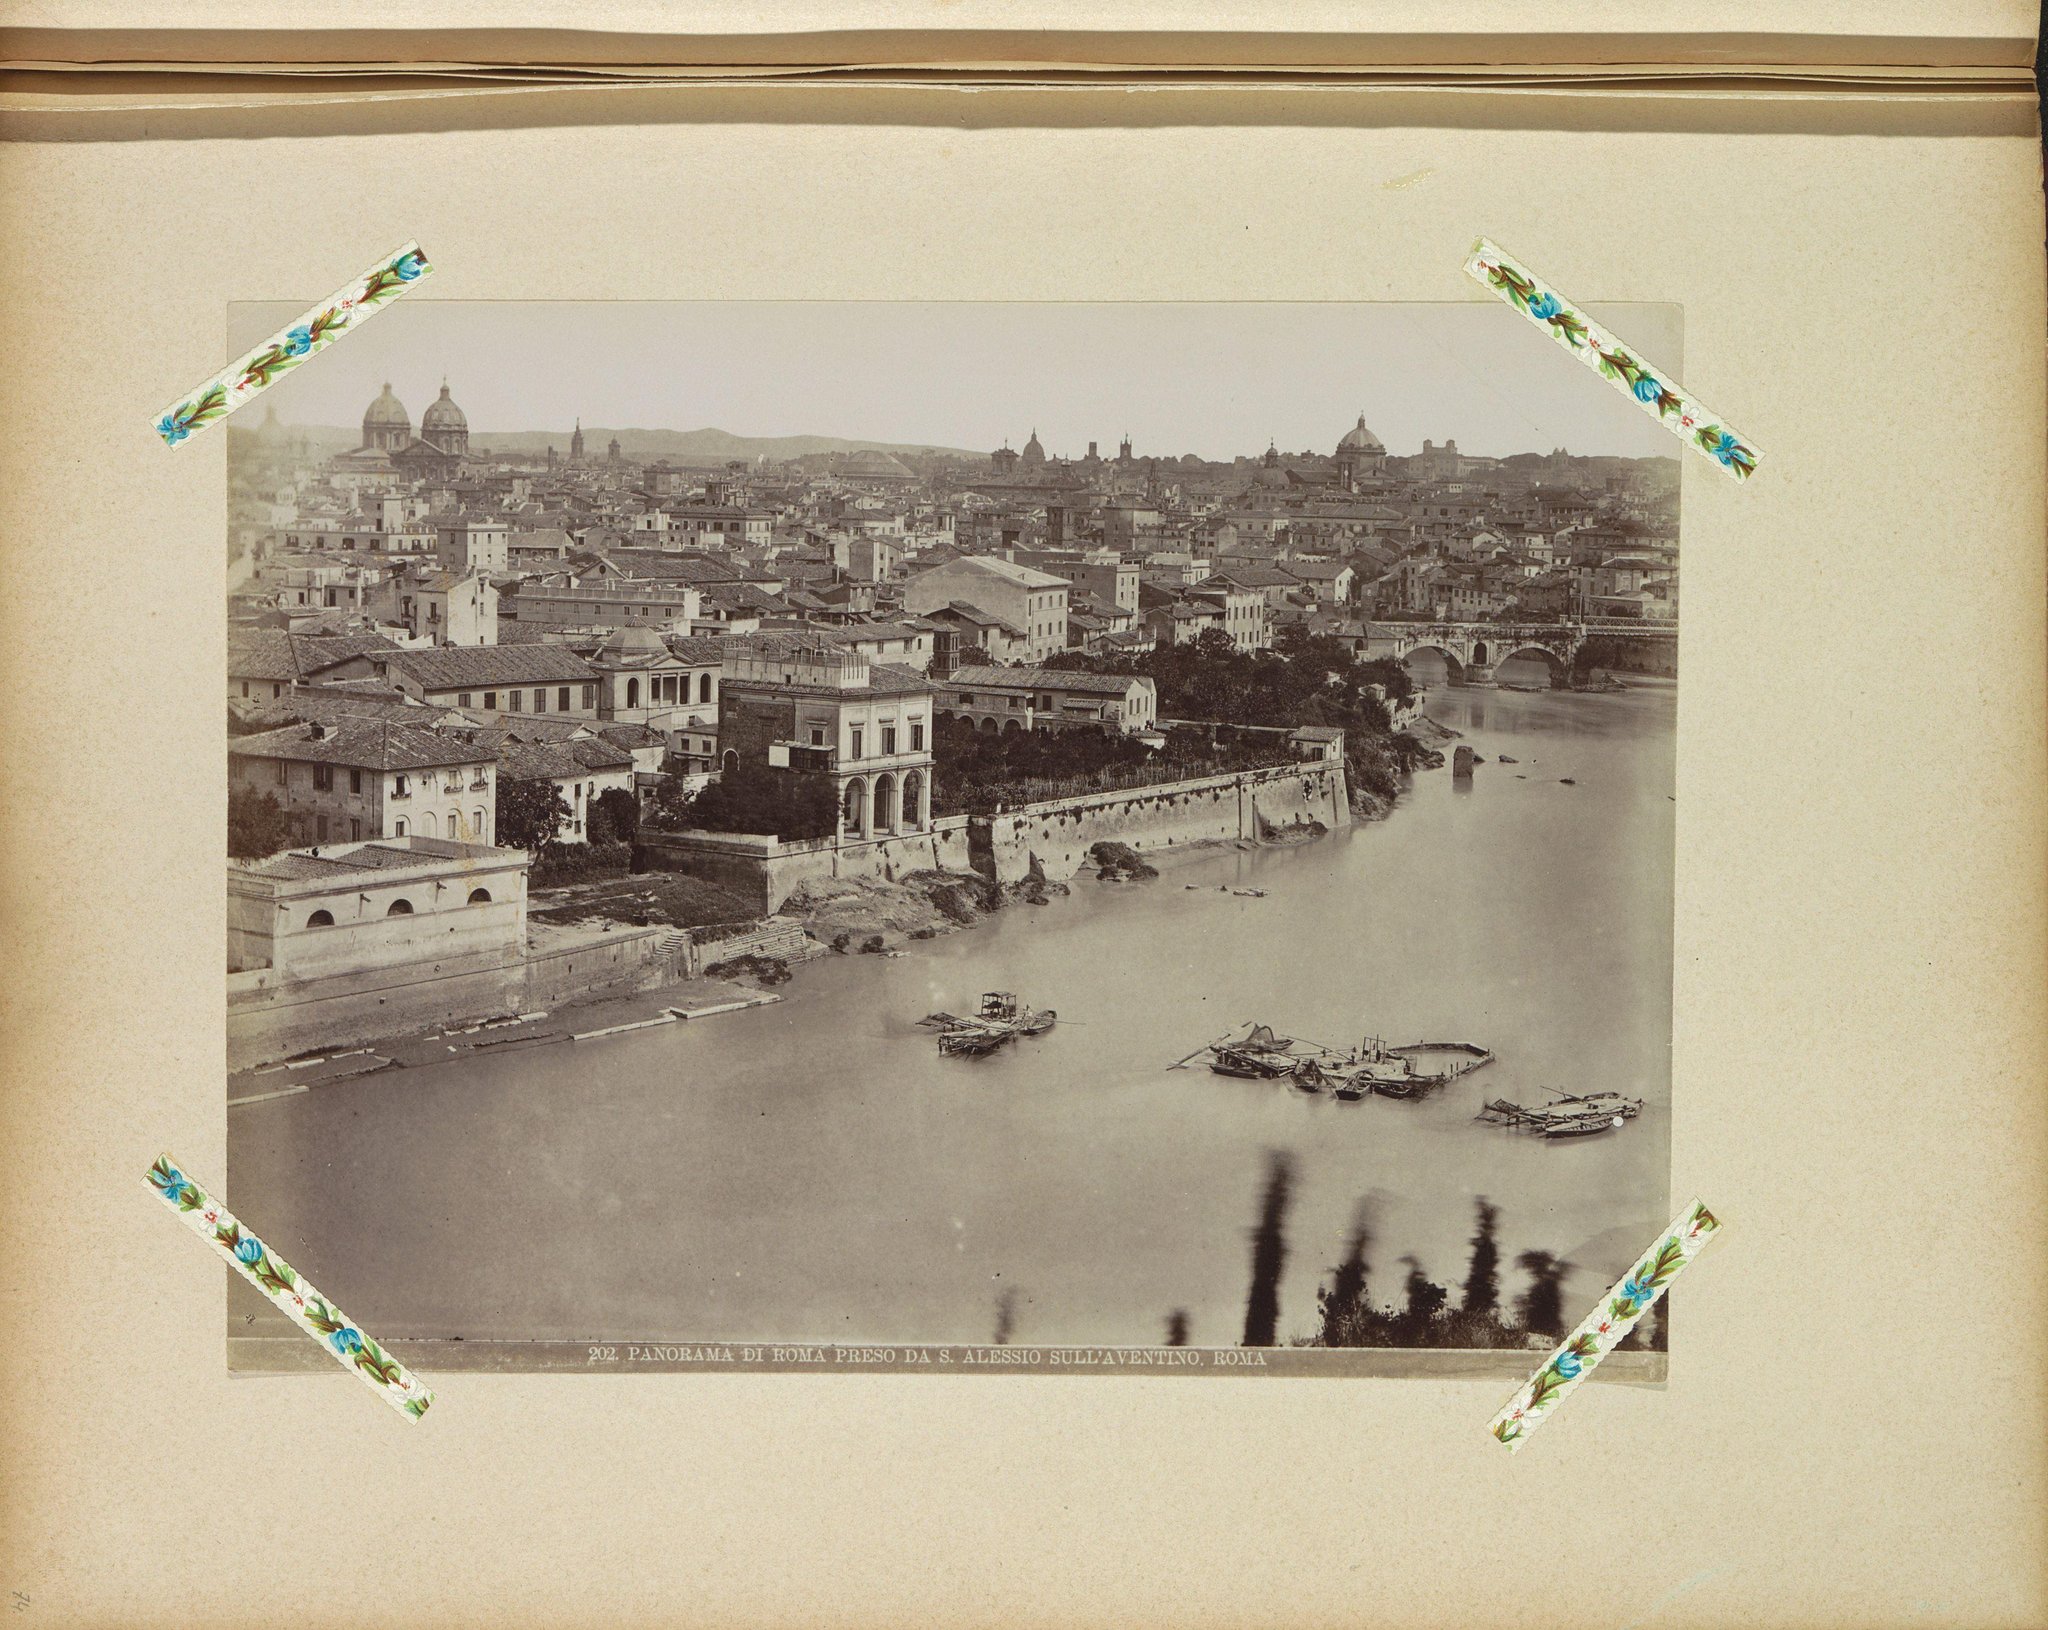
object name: photograph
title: Gezicht op Rome vanaf Basiliek van Sint-Bonifatius en Alexius op de Aventijn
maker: Anonymous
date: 1860-1900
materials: photographic support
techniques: albumen print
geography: rome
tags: bridge in city across river, canal, etc., prospect of city, town panorama, silhouette of city, rome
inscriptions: number: ‘202’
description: Onderdeel van Fotoalbum met opnames van bezienswaardigheden in Italiaanse steden en van kunstwerken.